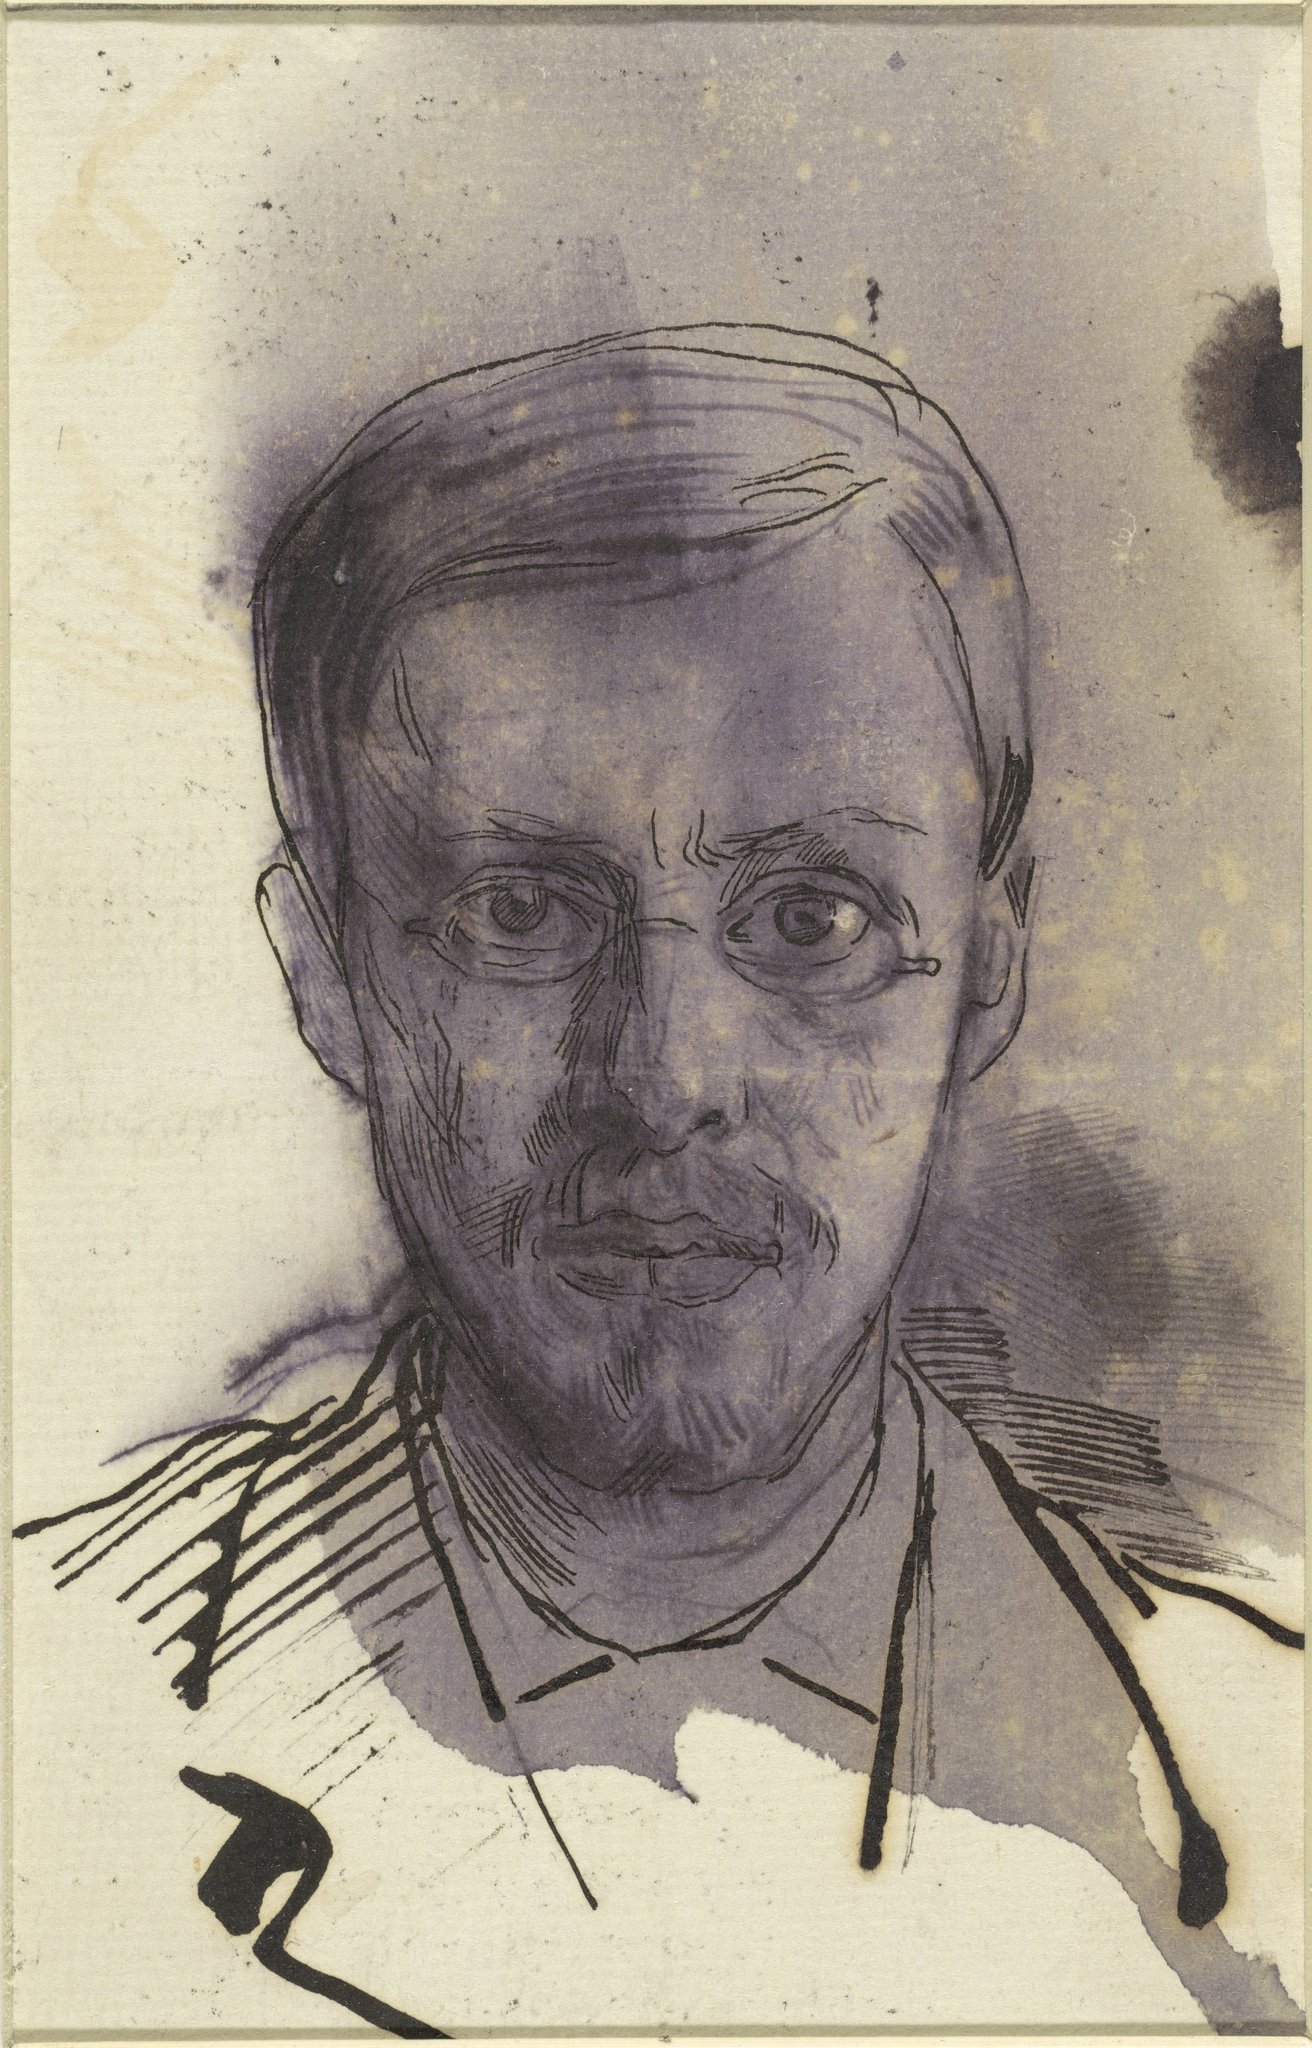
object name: drawing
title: Zelfportret van Jan Veth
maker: jan veth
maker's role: designer, draughtsman, painter, print maker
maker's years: 1864-1925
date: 1874-1925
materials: ink, paper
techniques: brush, pen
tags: dordrecht, amsterdam, painter, print maker, draughtsman, designer, jan veth, historical persons, portrait, self-portrait of painter, portrait, self-portrait of artist, portrait, self-portrait of graphic artist, portrait, self-portrait of draughtsman